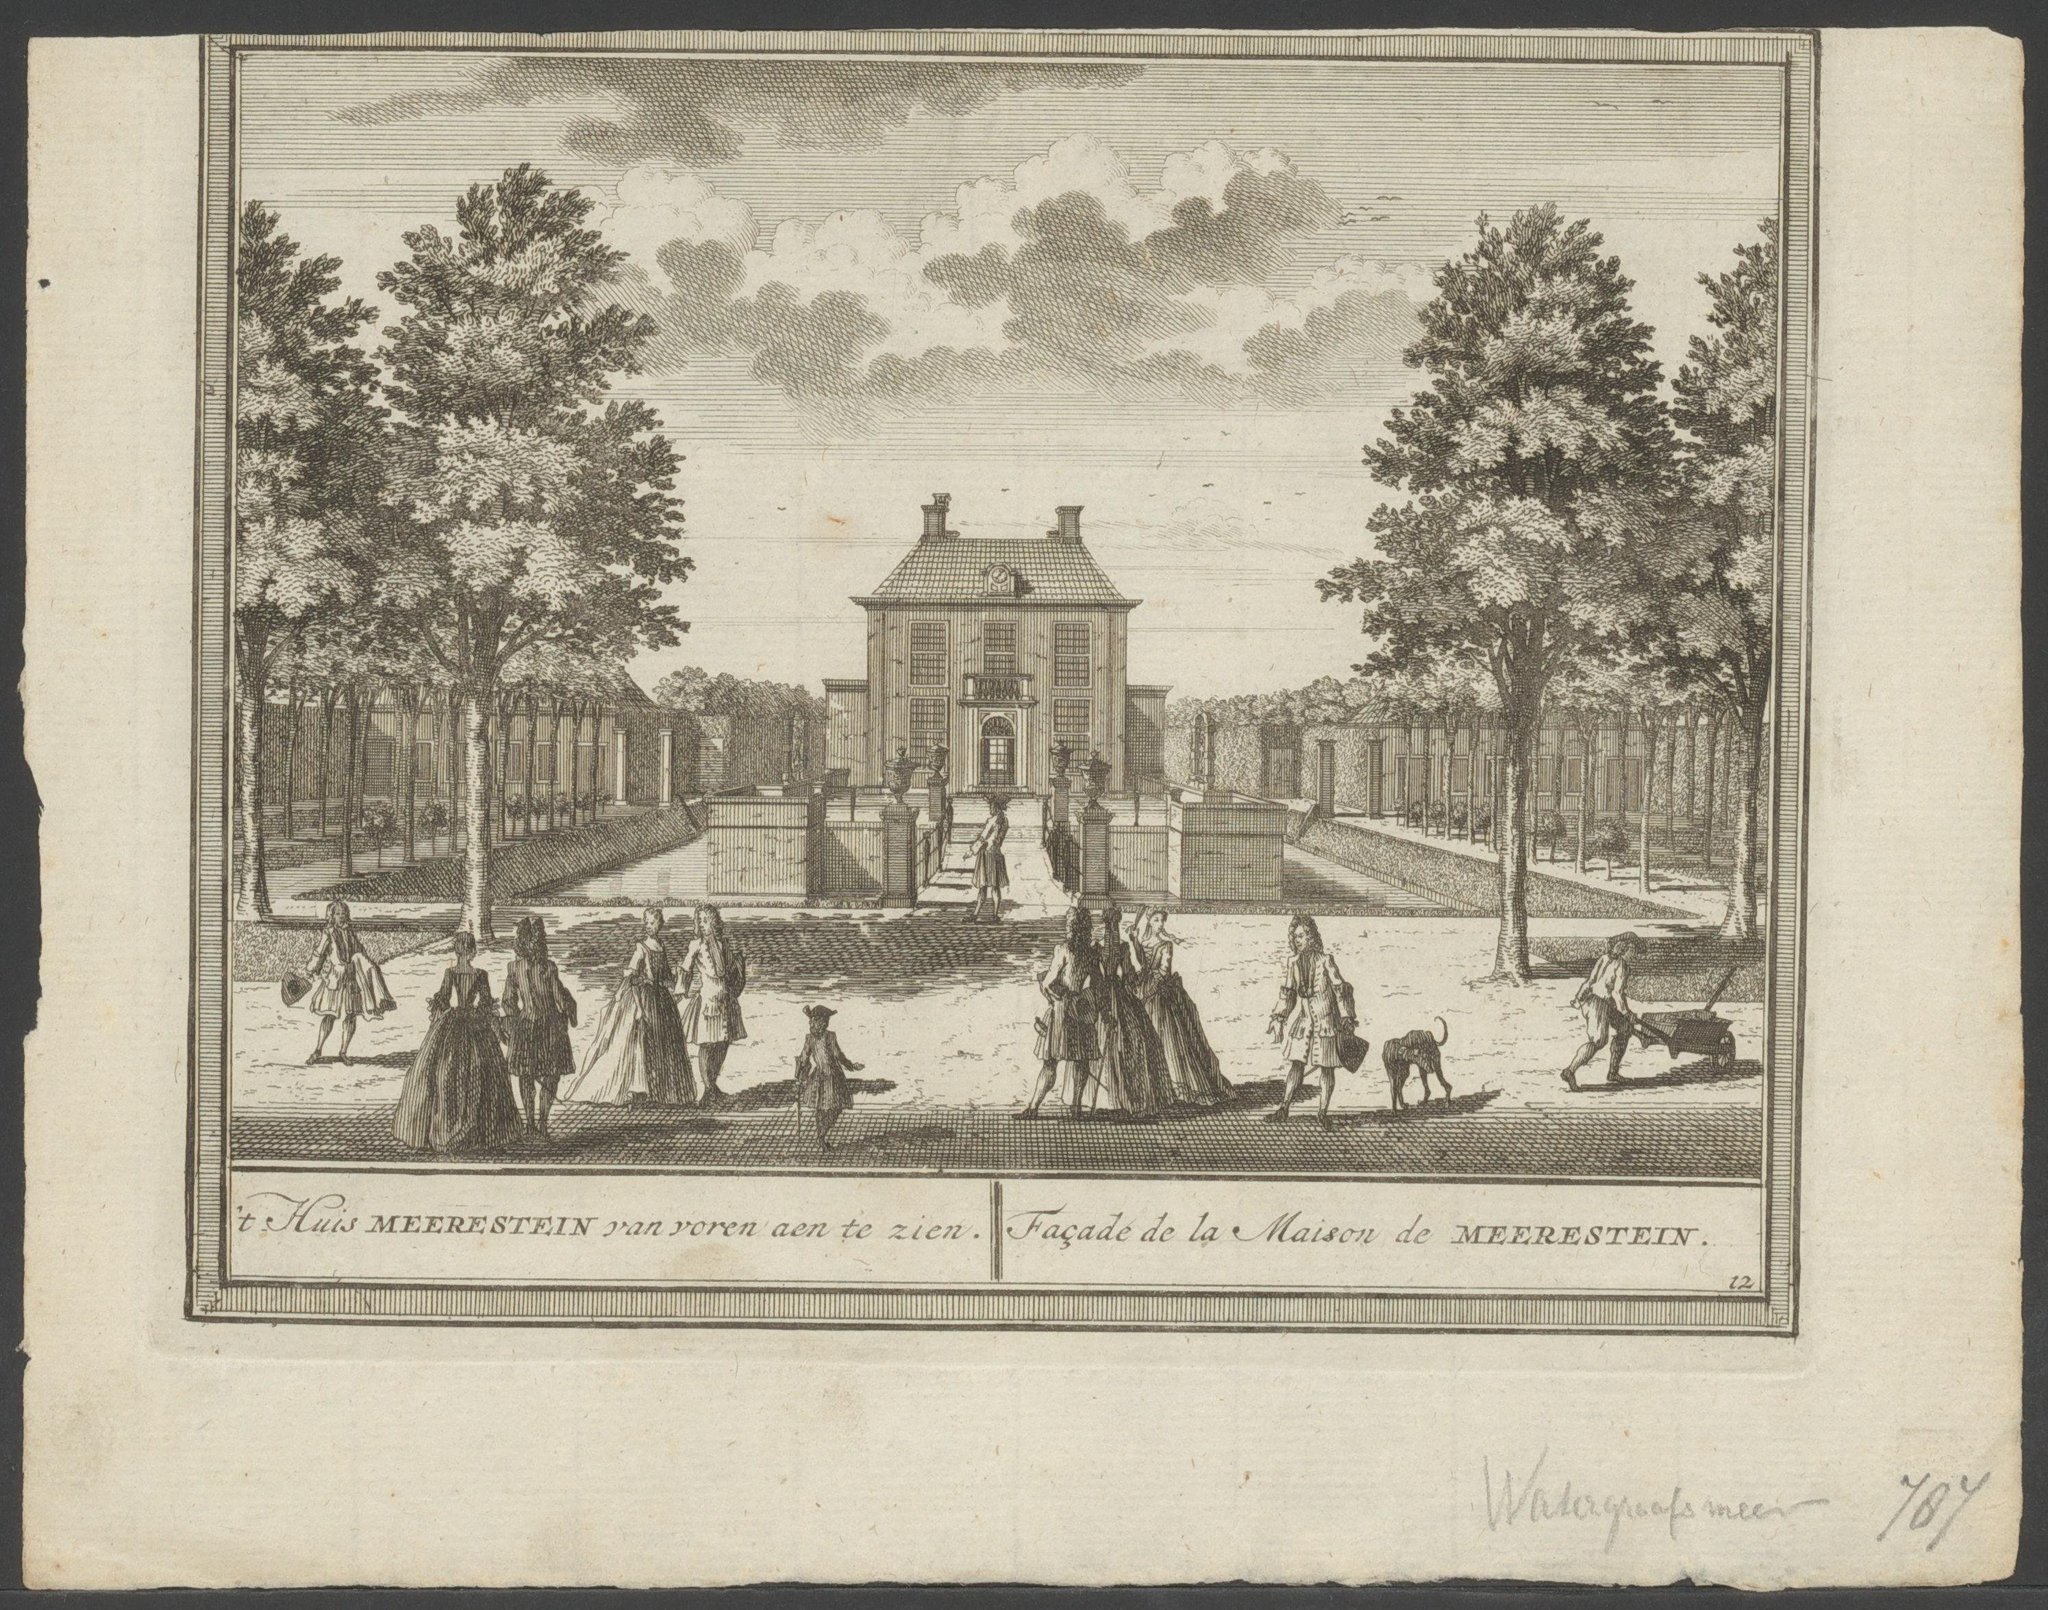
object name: print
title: 't Huis Meerestein van voren aen te zien / Façade de la Maison de Meerestein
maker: hendrik de leth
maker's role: draughtsman, print maker, publisher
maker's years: 1703-1766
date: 1770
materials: paper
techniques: engraving, etching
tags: rural housing, e.g. country-house, villa, cottage, lane, alley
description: Prent mogelijk uit: Nidek, Matthaeus Brouërius. Het zegenpralent Kennemerlant, vertoont in veele heerelyke gezichten van deszelfs voornaemste lustplaetzen, adelyke huizen, dorp- en stede-gebouwen (...). Amsterdam: Andries en Hendrik de Leth, 1770.